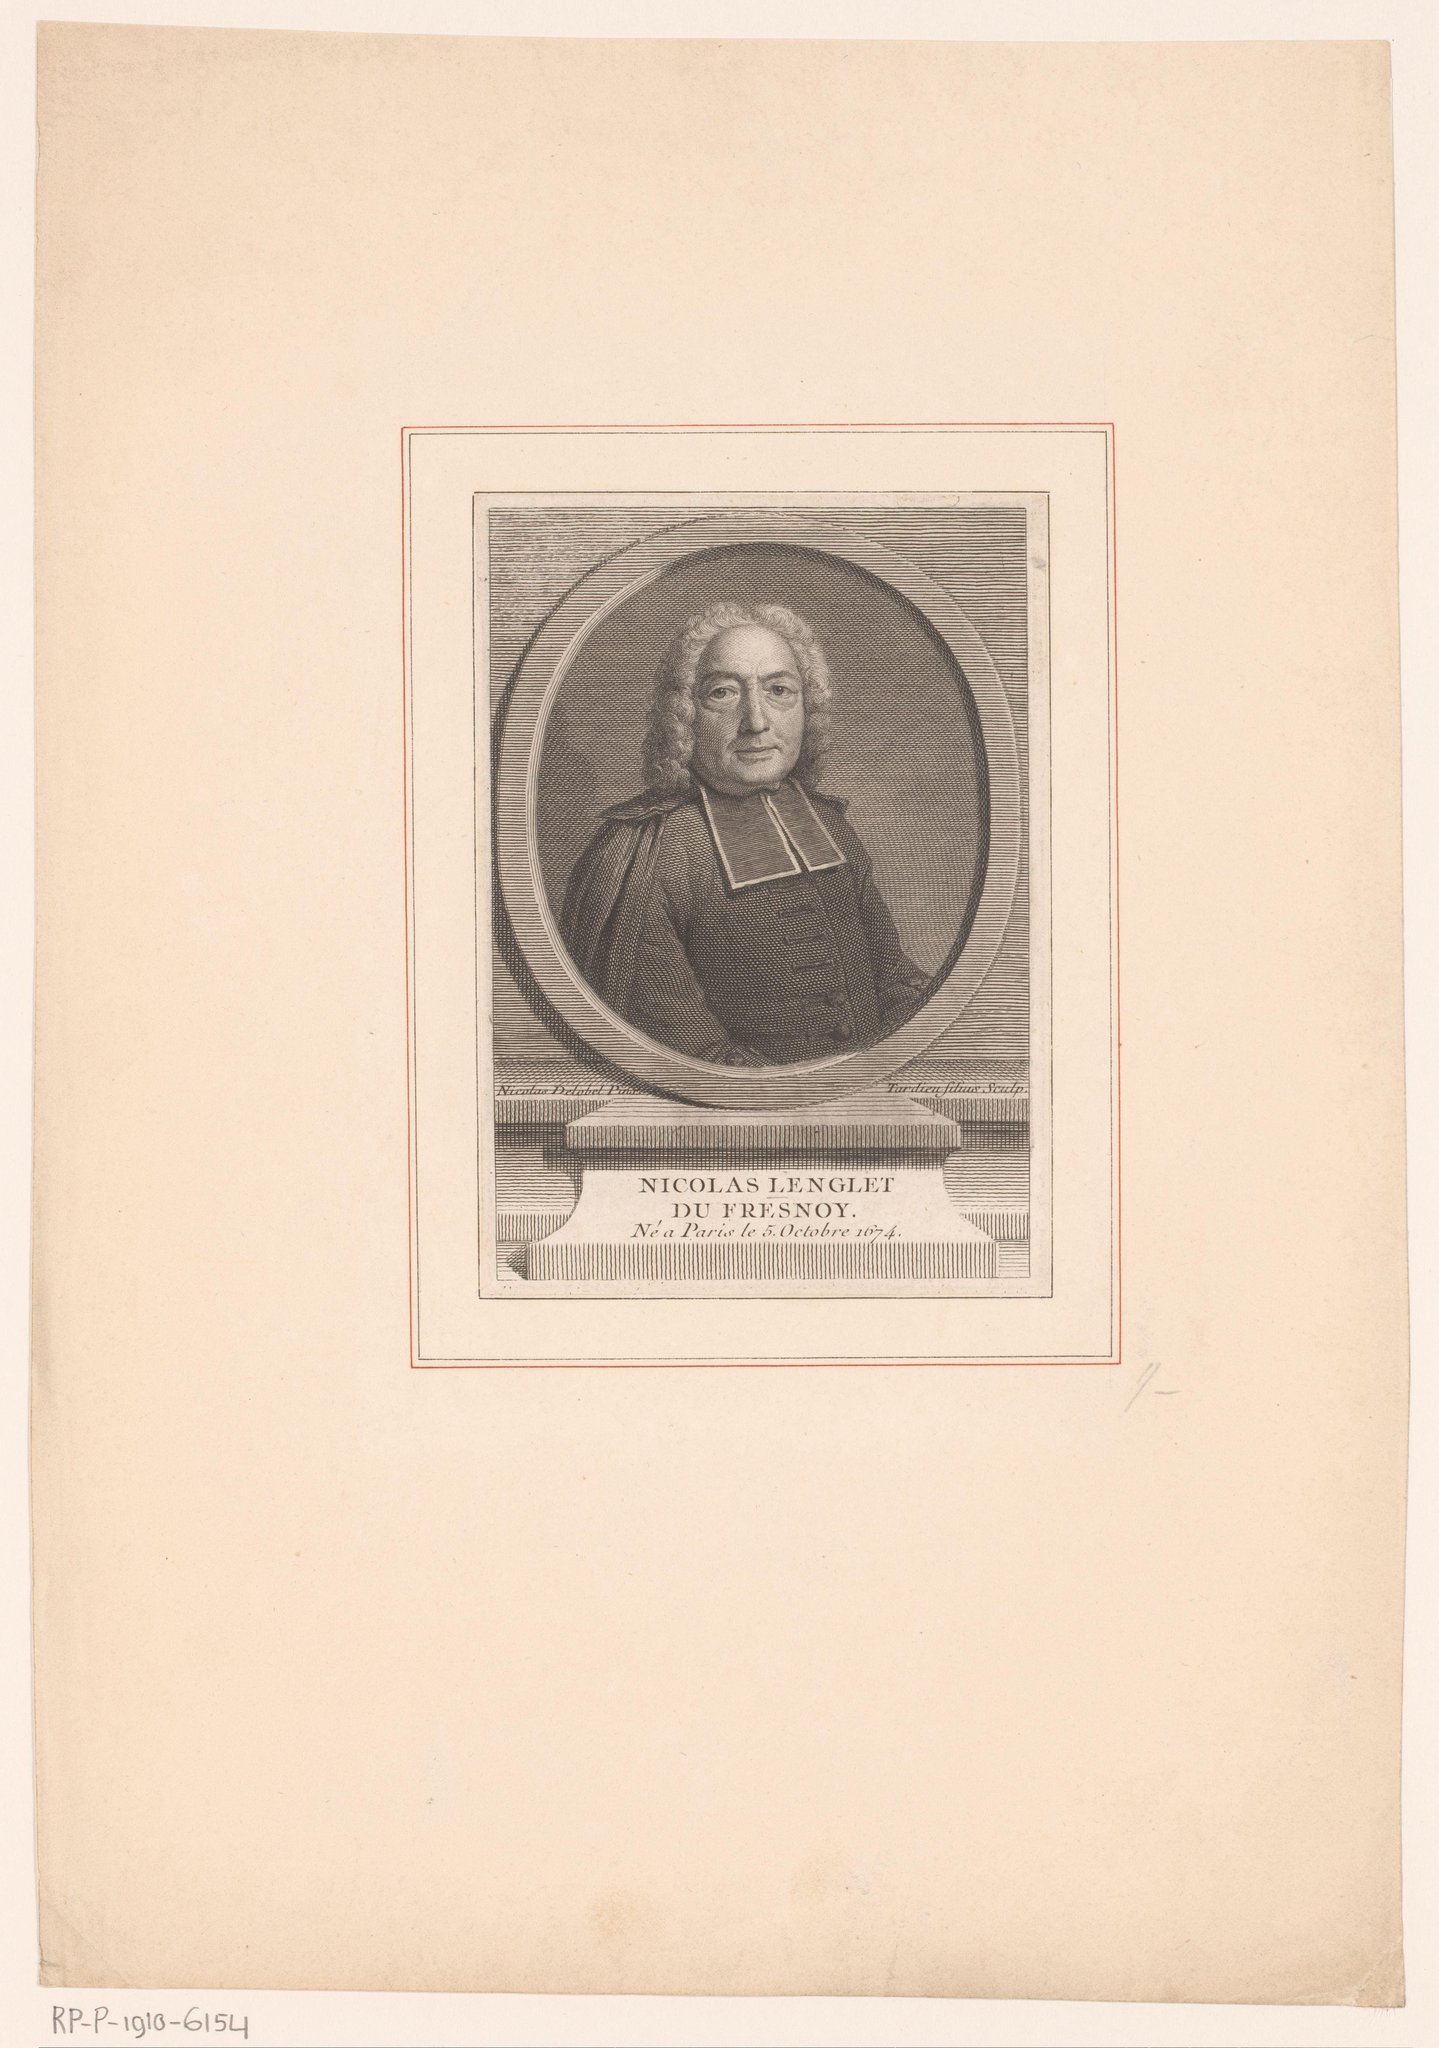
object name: print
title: Portret van Nicolas Lenglet-Dufresnoy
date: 1755-1765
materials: paper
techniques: engraving, etching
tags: beauvais, historical persons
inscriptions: collector's mark: Lugt 2228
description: Prent als illustratie gebruikt voor het boek: Dreux de Radier, Jean François. L'Europe illustre. Parijs: Michel Odieuvre, 1755-1765.